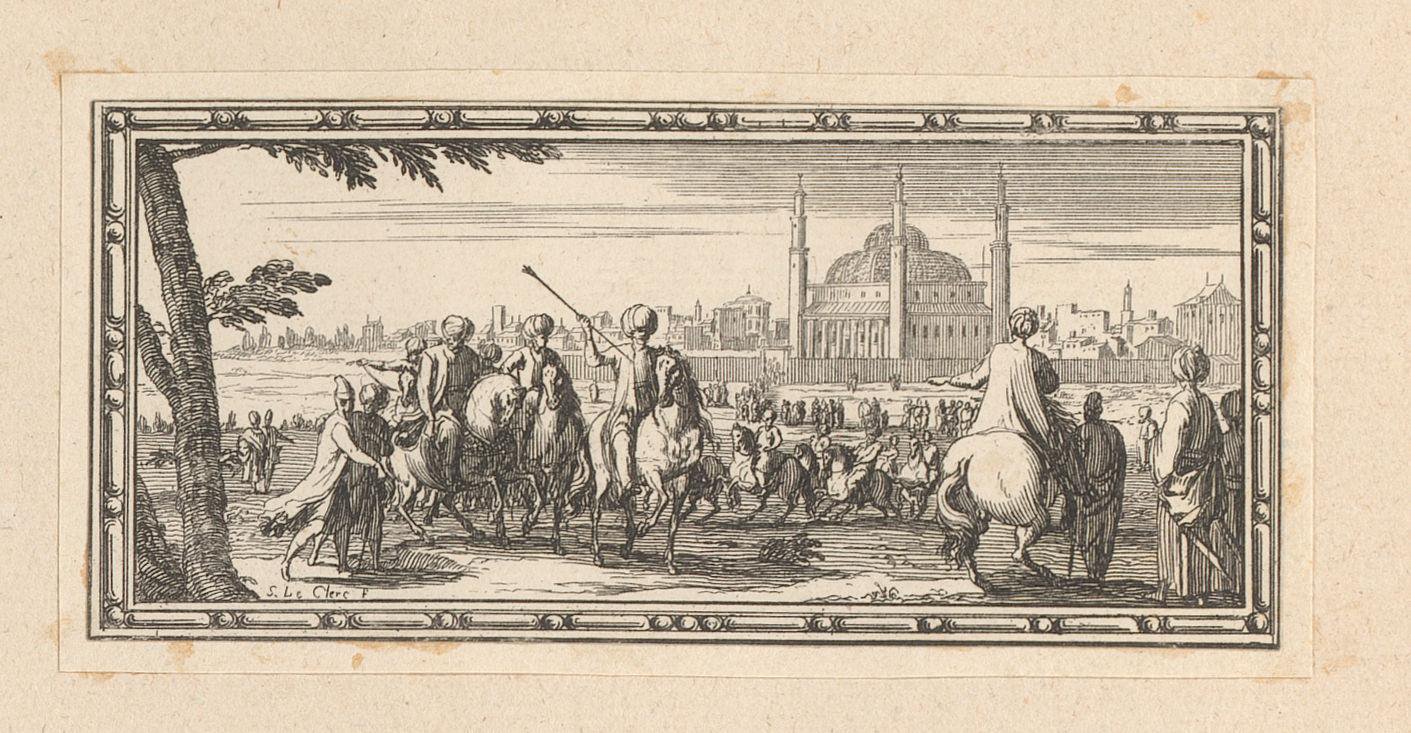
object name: print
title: Vignet met ruiters met op de achtergrond een moskee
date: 1670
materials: paper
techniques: etching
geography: paris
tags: temple, shrine ~ islam, mohammedanism, vignette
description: Prent gebruikt voor: Rycaut, Paul. Histoire de l'état présent de l'Empire ottoman (...). Parijs: Sébastien Mabre-Cramoisy, 1670.